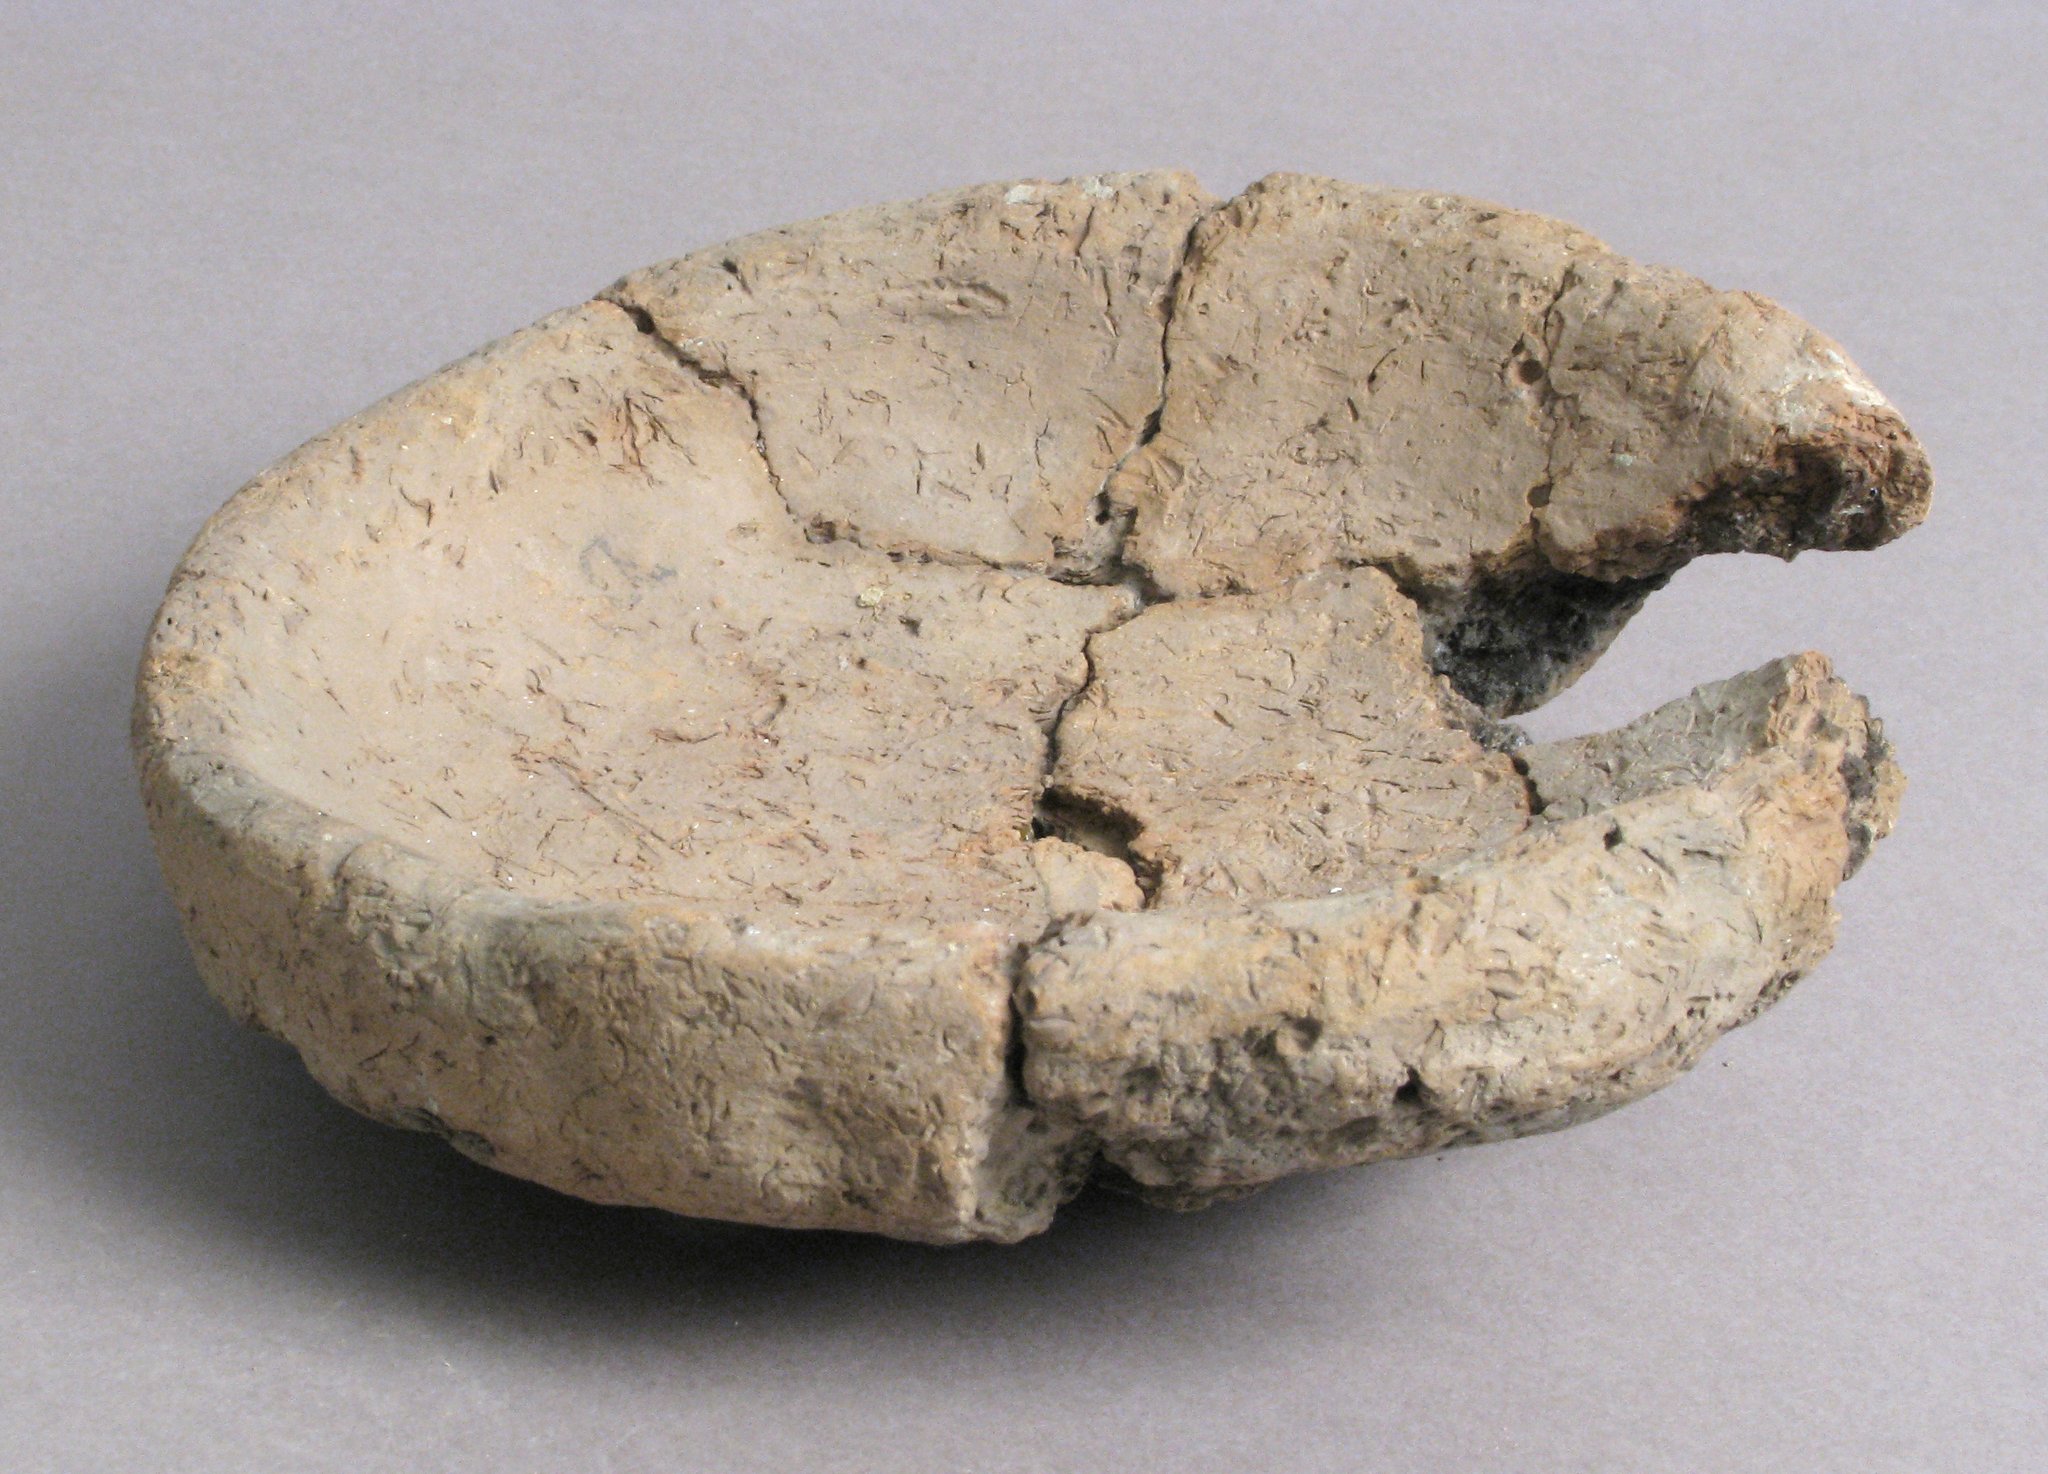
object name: plate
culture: coptic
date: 301-700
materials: earthenware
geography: egypt